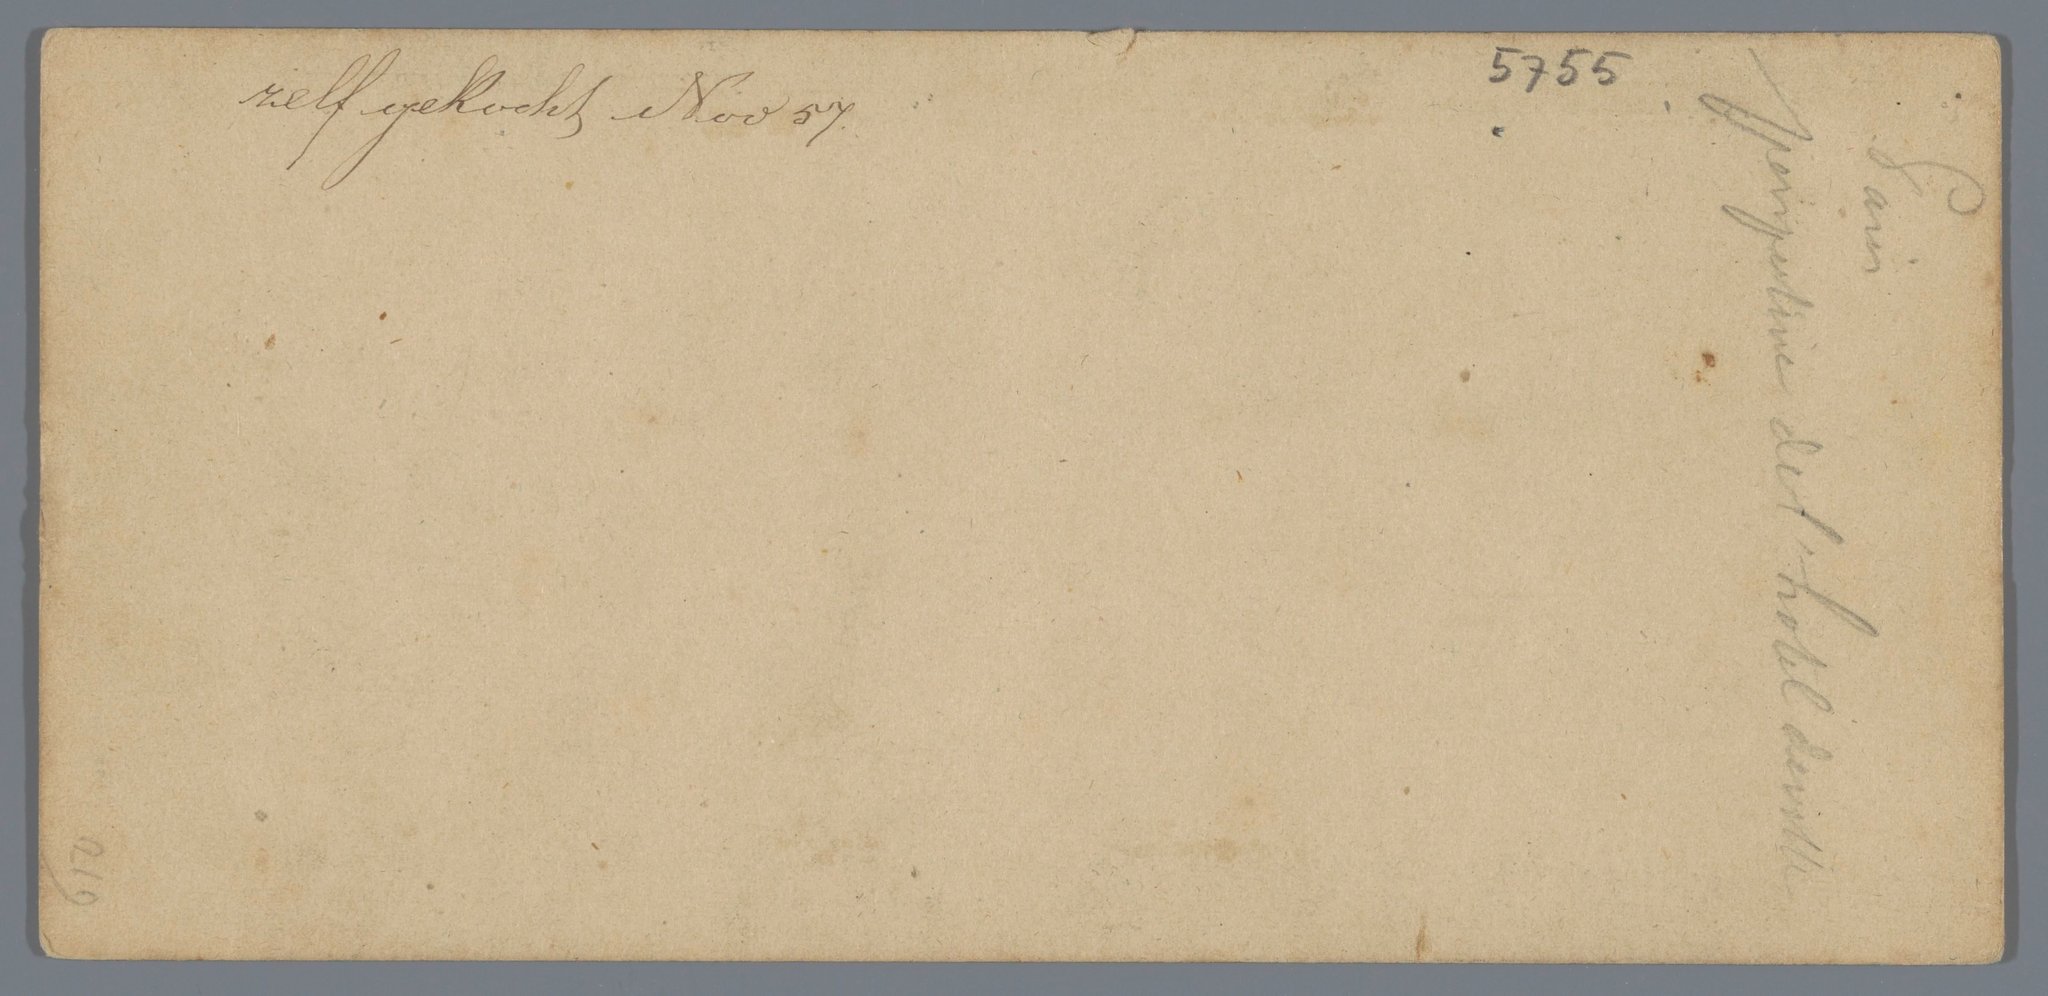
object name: stereograph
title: Gezicht over de Seine en het stadhuis van Parijs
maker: Anonymous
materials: cardboard, photographic support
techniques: albumen print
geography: paris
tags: river, townhall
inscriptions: inscription: ‘zelf gekocht Nov 57.’, inscription: ‘Paris perspective de l'hotel de ville’